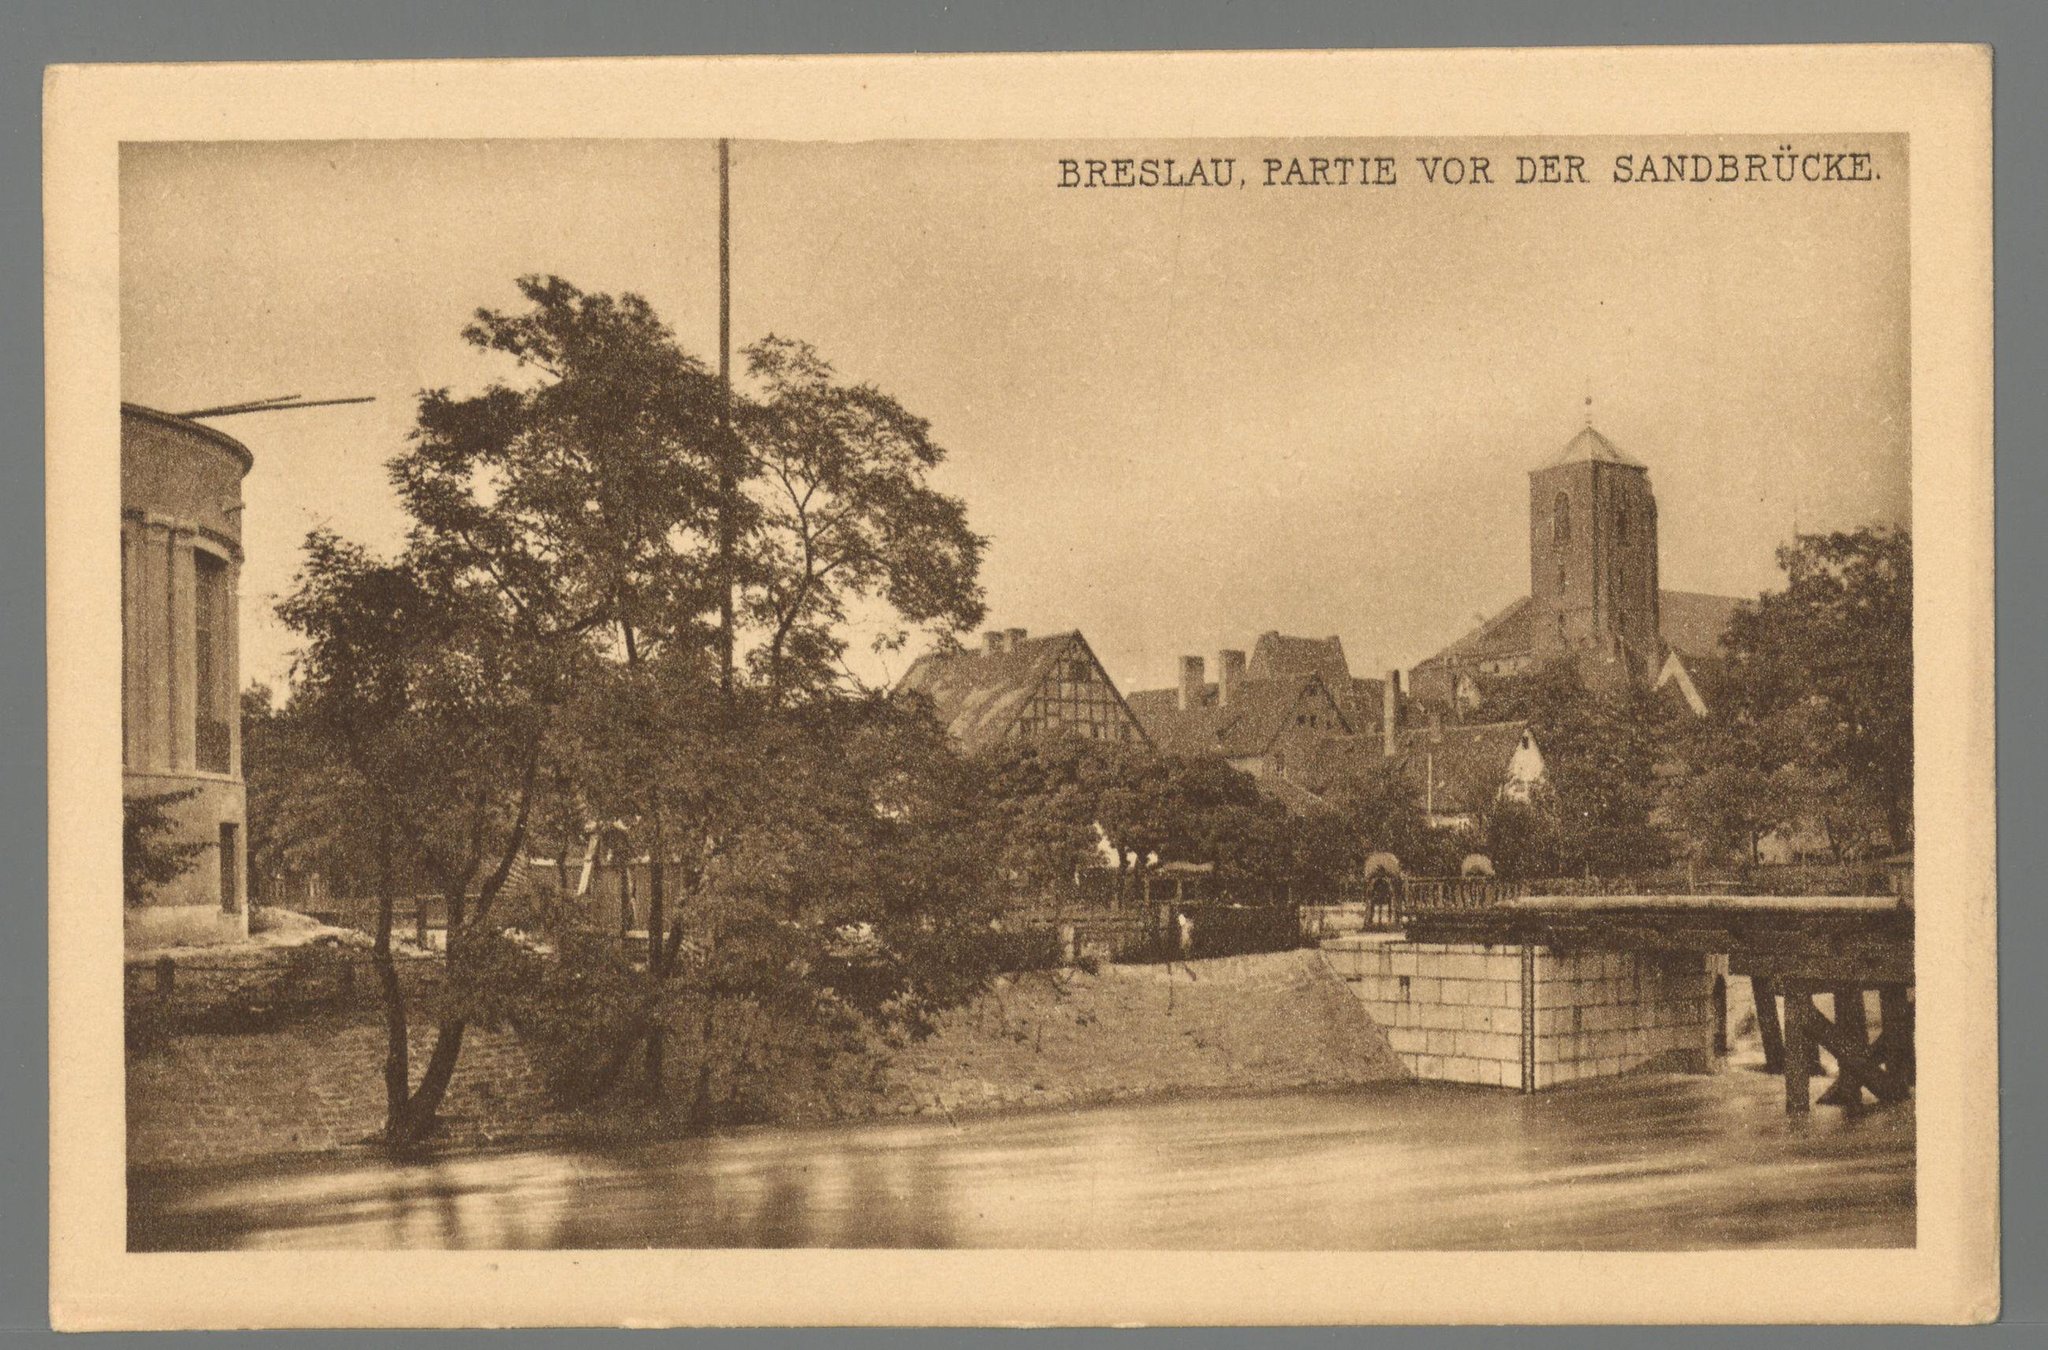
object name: photomechanical print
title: Breslau, partie vor der Sandbrücke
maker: Anonymous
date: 1905-1930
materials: cardboard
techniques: rotogravure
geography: berlin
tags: city-view, and landscape with man-made constructions, canals, waters (in city), bridge in city across river, canal, etc.